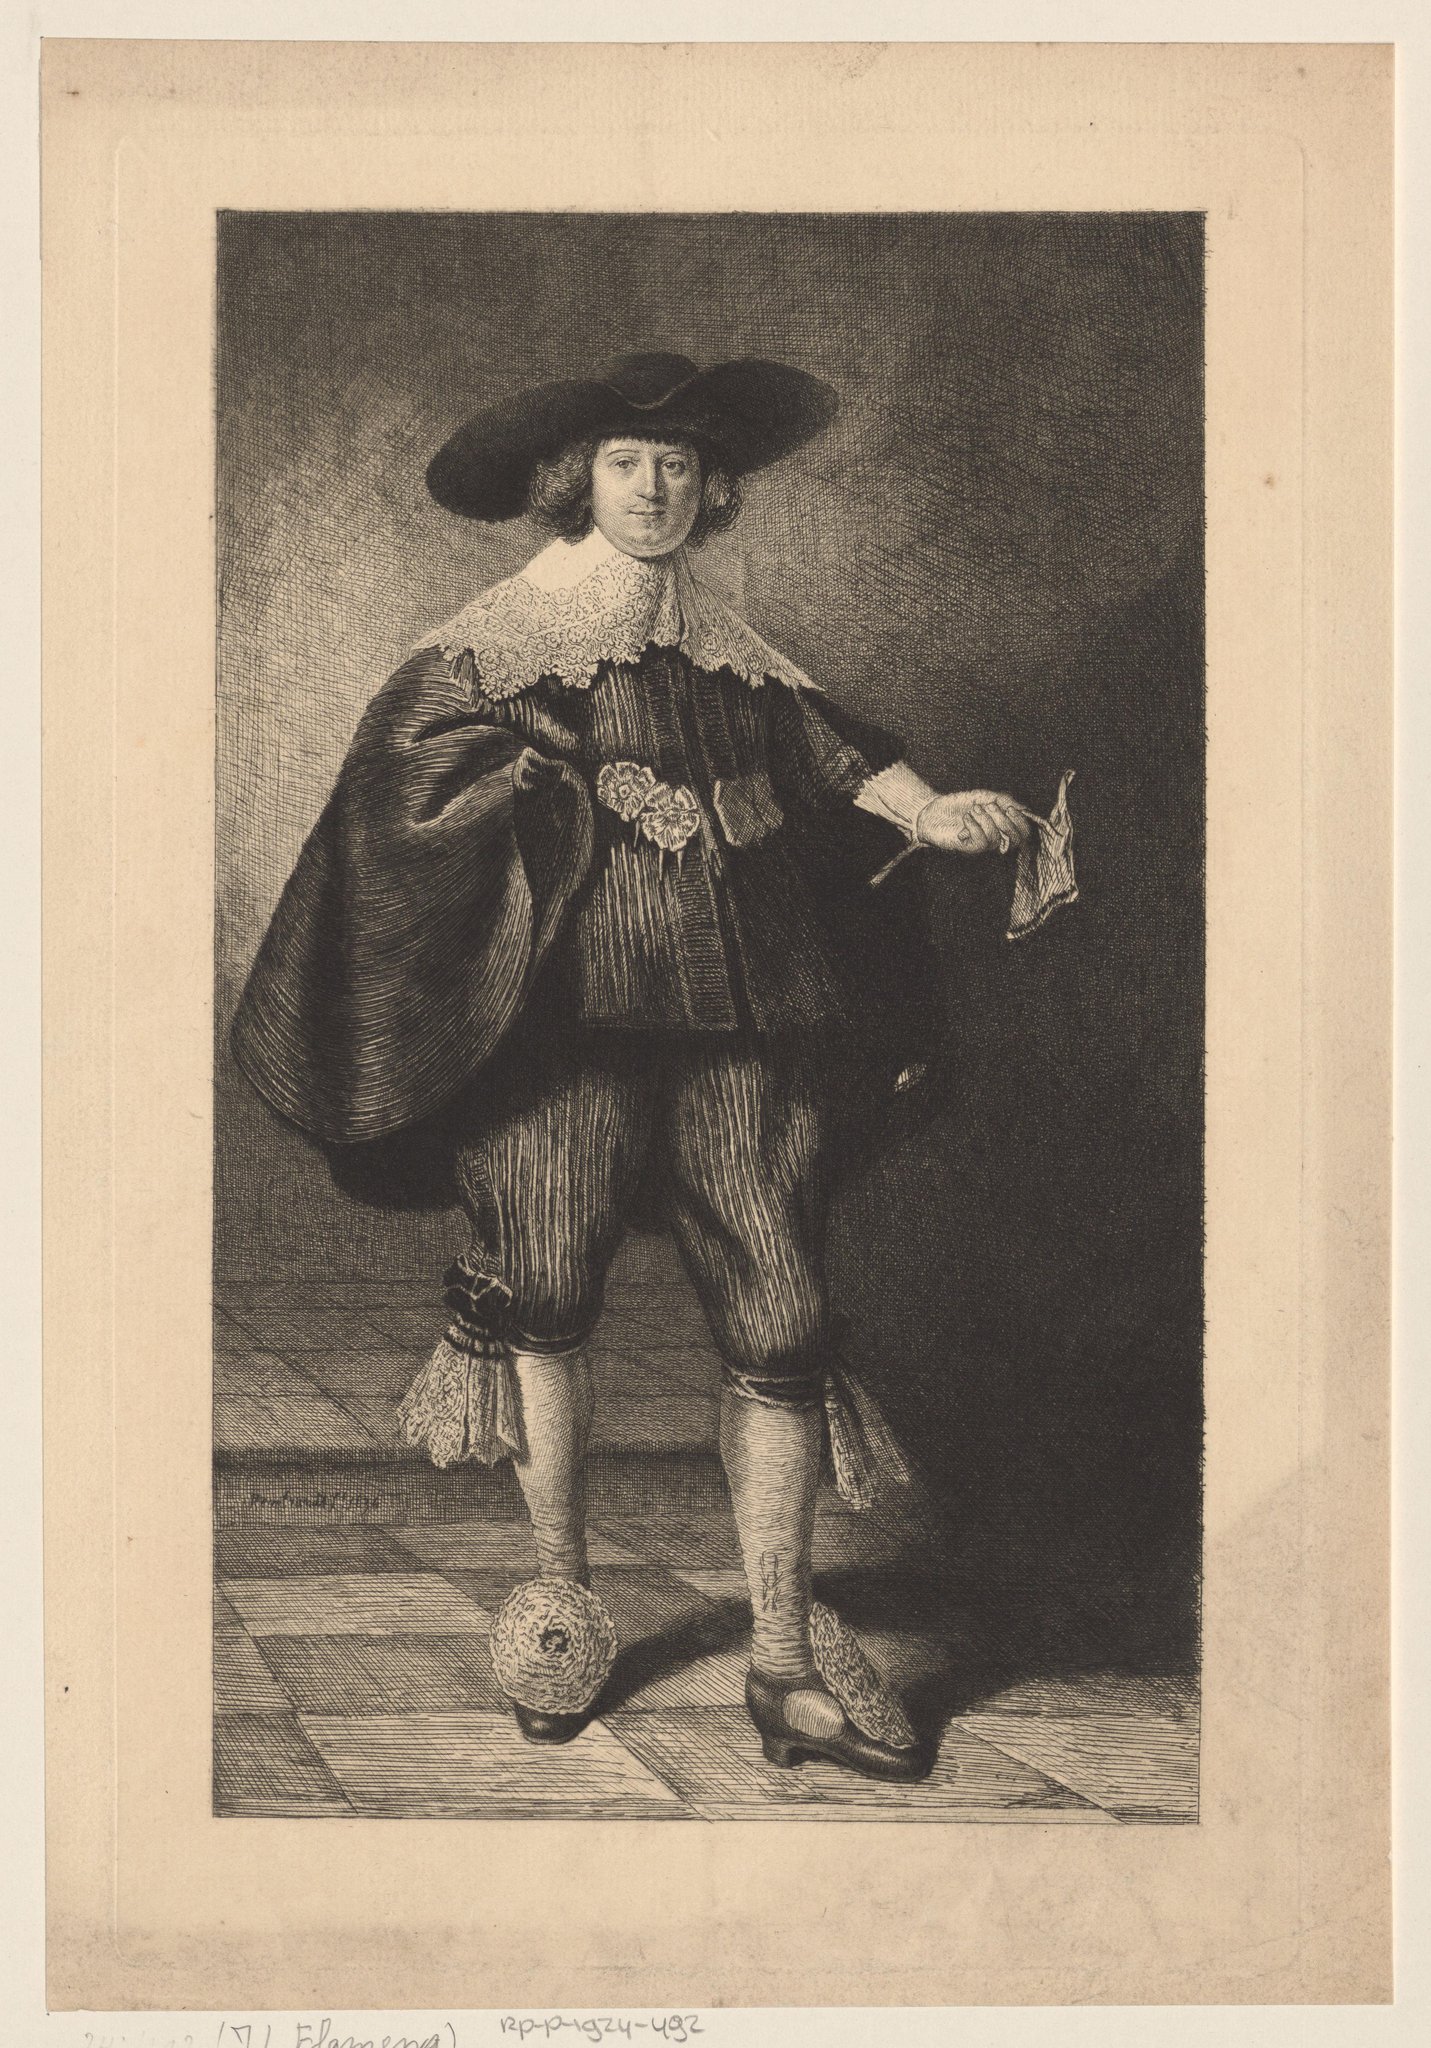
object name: print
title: Portret van Marten Soolmans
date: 1879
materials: paper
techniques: drypoint, etching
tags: historical persons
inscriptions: collector's mark: Lugt 2233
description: Prent waarschijnlijk uit: Nederlandsche Kunstbode (...), 22 maart 1879. Prent in eerdere staat gebruikt in: La Gazette des Beaux-Arts, 1 januari 1879.